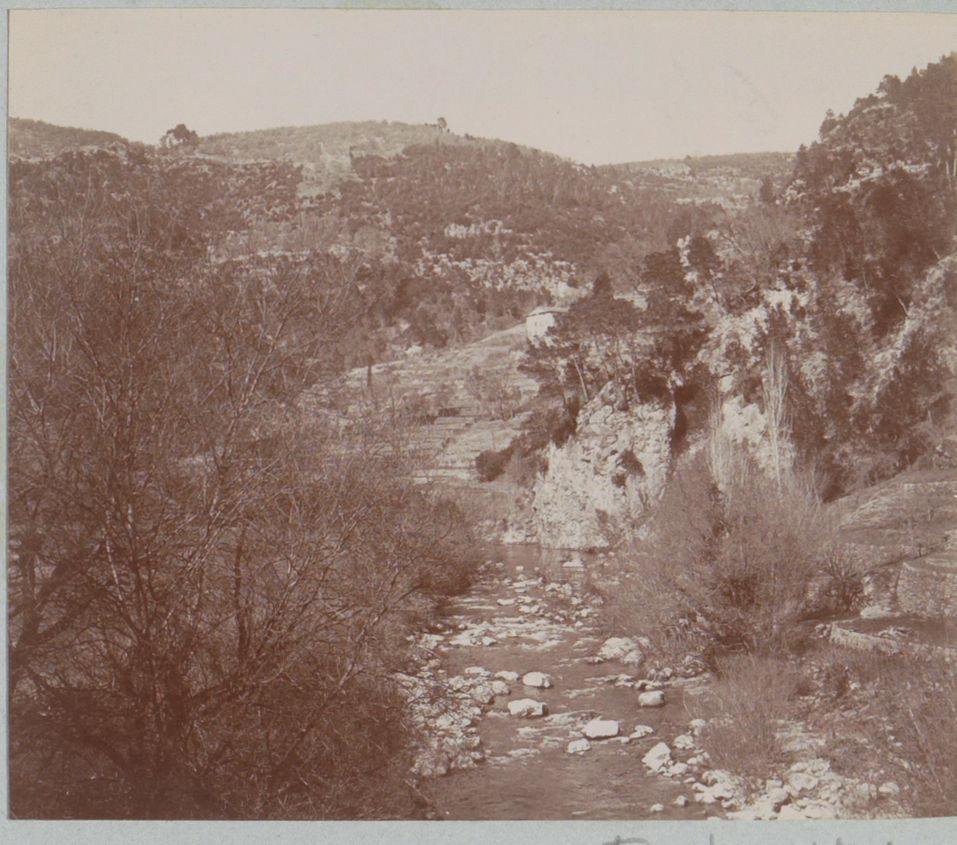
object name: photograph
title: Berglandschap met een beek, vermoedelijk in Zuid-Frankrijk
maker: Anonymous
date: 1905-1910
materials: paper, photographic support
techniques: gelatin silver print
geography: southern france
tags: river (+ landscape with figures, staffage)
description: Onderdeel van Fotoalbum van een Franse amateurfotograaf met bezienswaardigheden in Frankrijk, Zwitserland en Italië.